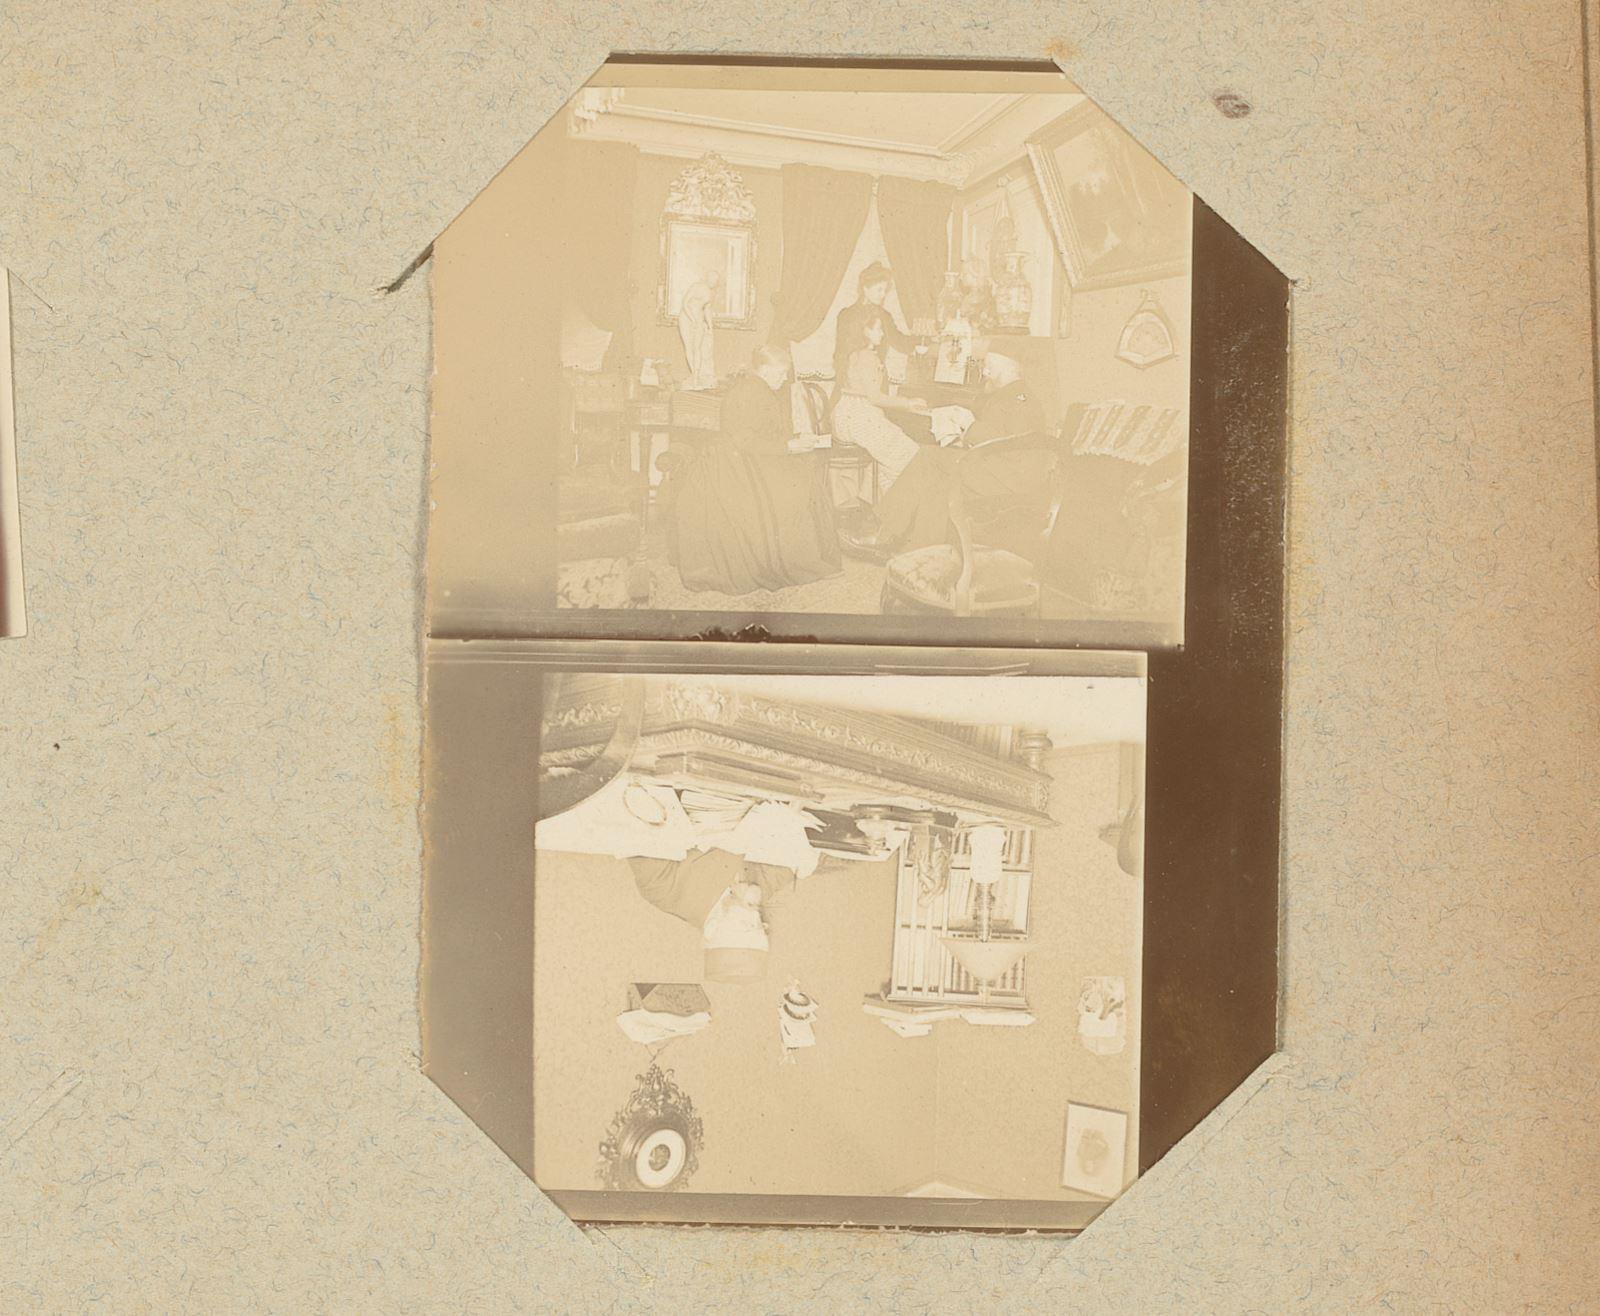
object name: album leaf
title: Twee opnames van een tafereel in een huiskamer en een man aan een bureau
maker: Anonymous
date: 1897-1900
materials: paper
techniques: gelatin silver print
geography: france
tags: writing-table, writing-desk, living-room, parlour, sitting-room, france